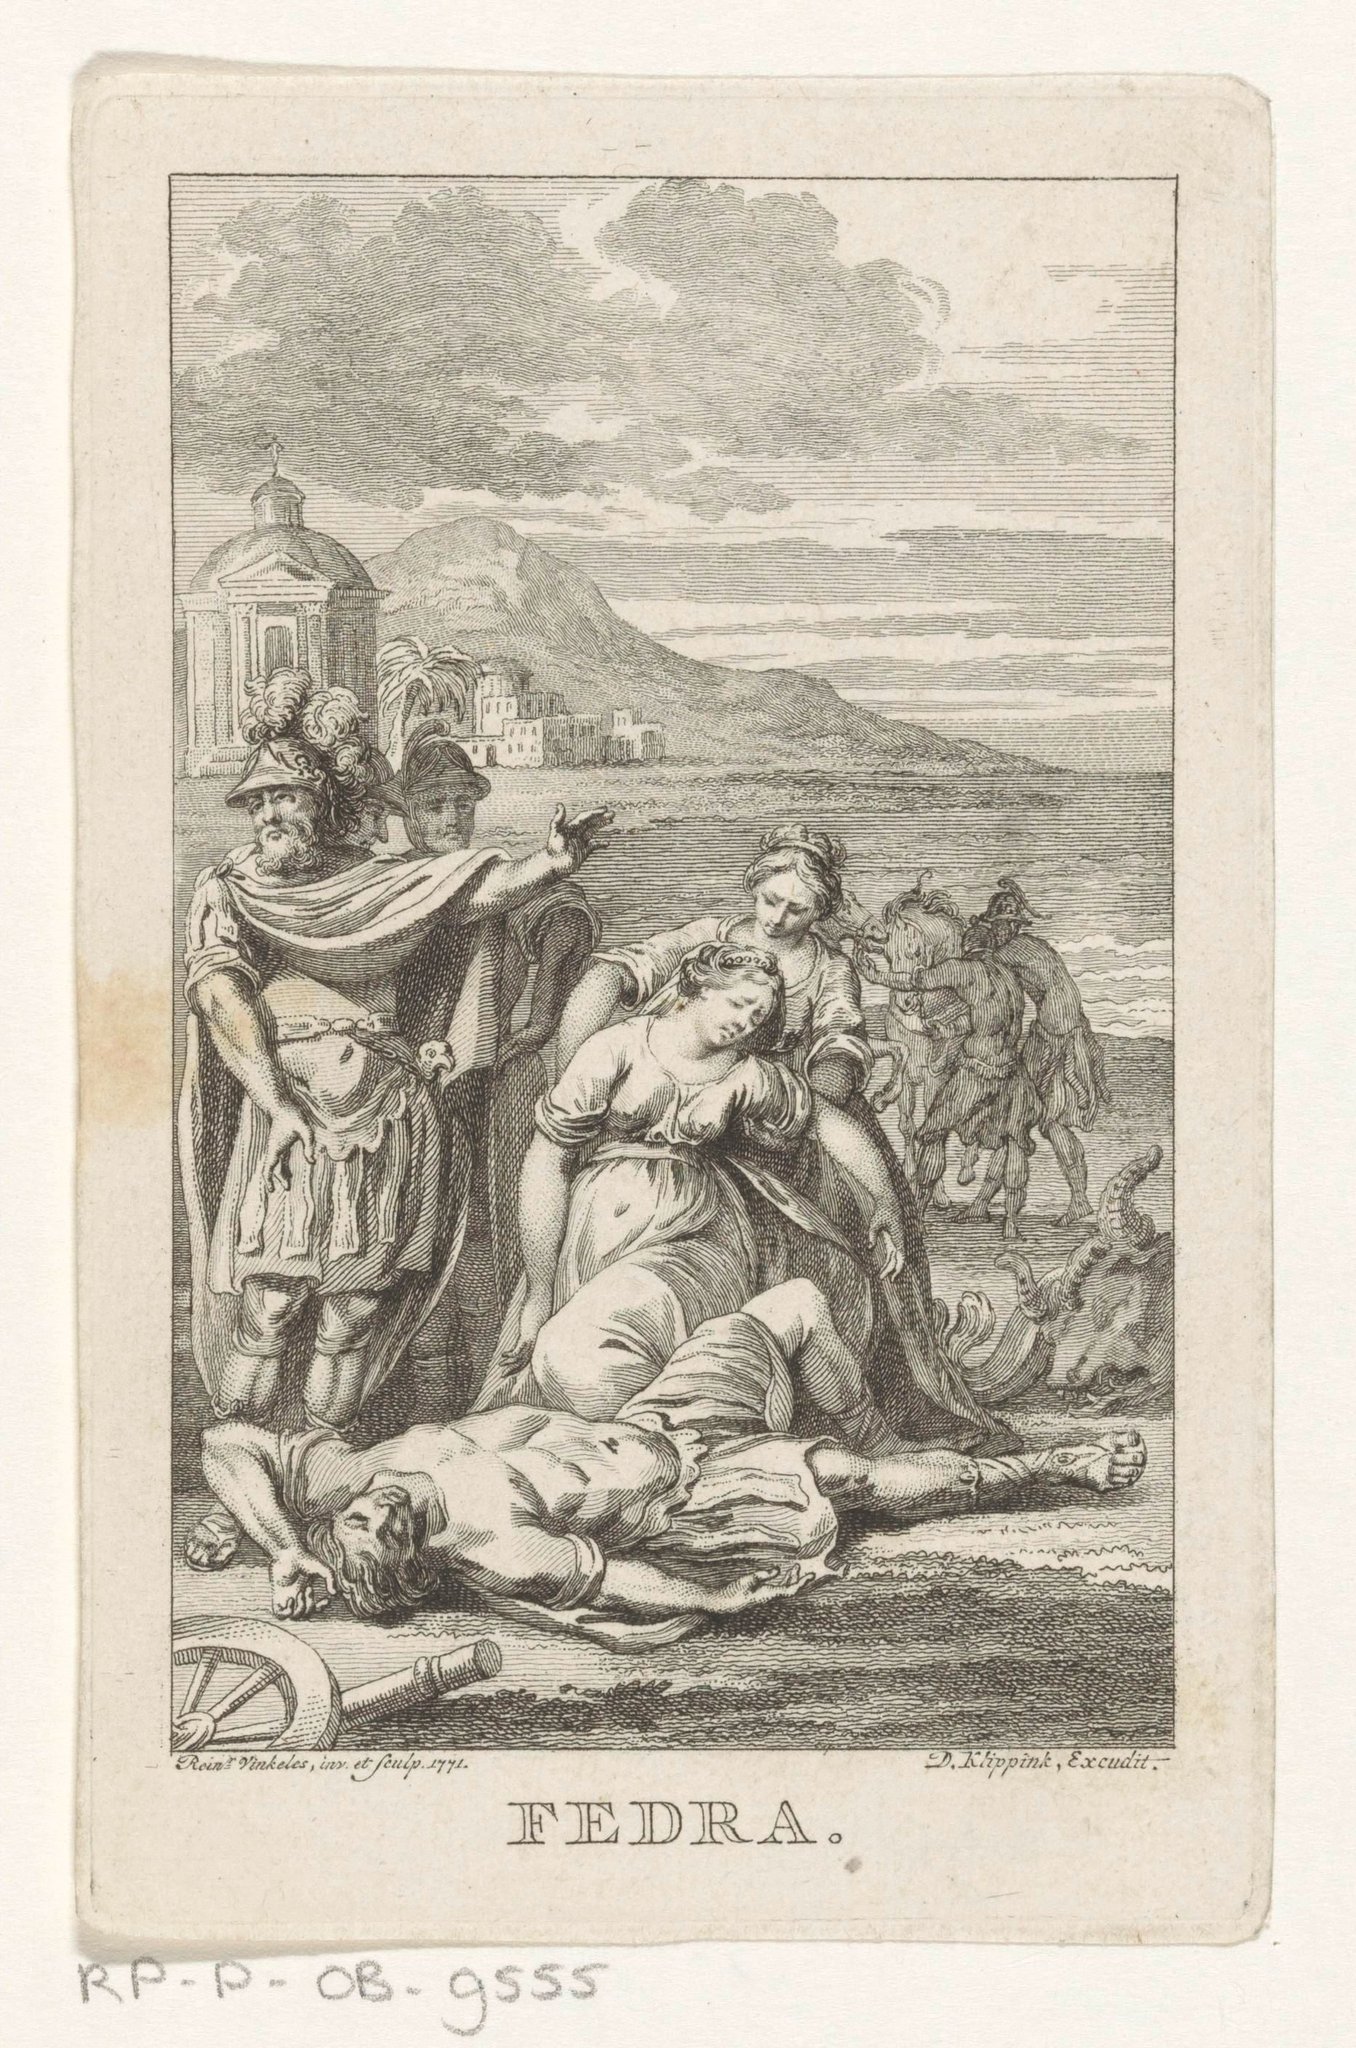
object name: titelblad, titelpagina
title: Fedra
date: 1771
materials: paper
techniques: engraving, etching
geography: amsterdam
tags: (story of) hippolytus, (story of) theseus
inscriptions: collector's mark: Lugt 2228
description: Theseus en twee vrouwen treuren bij het dode lichaam van Hippolytos. Op de voorgrond een deel van de gesneuvelde wagen waarmee Hippolytos verongelukte. In de achtergrond de stier en de onrustige paarden.